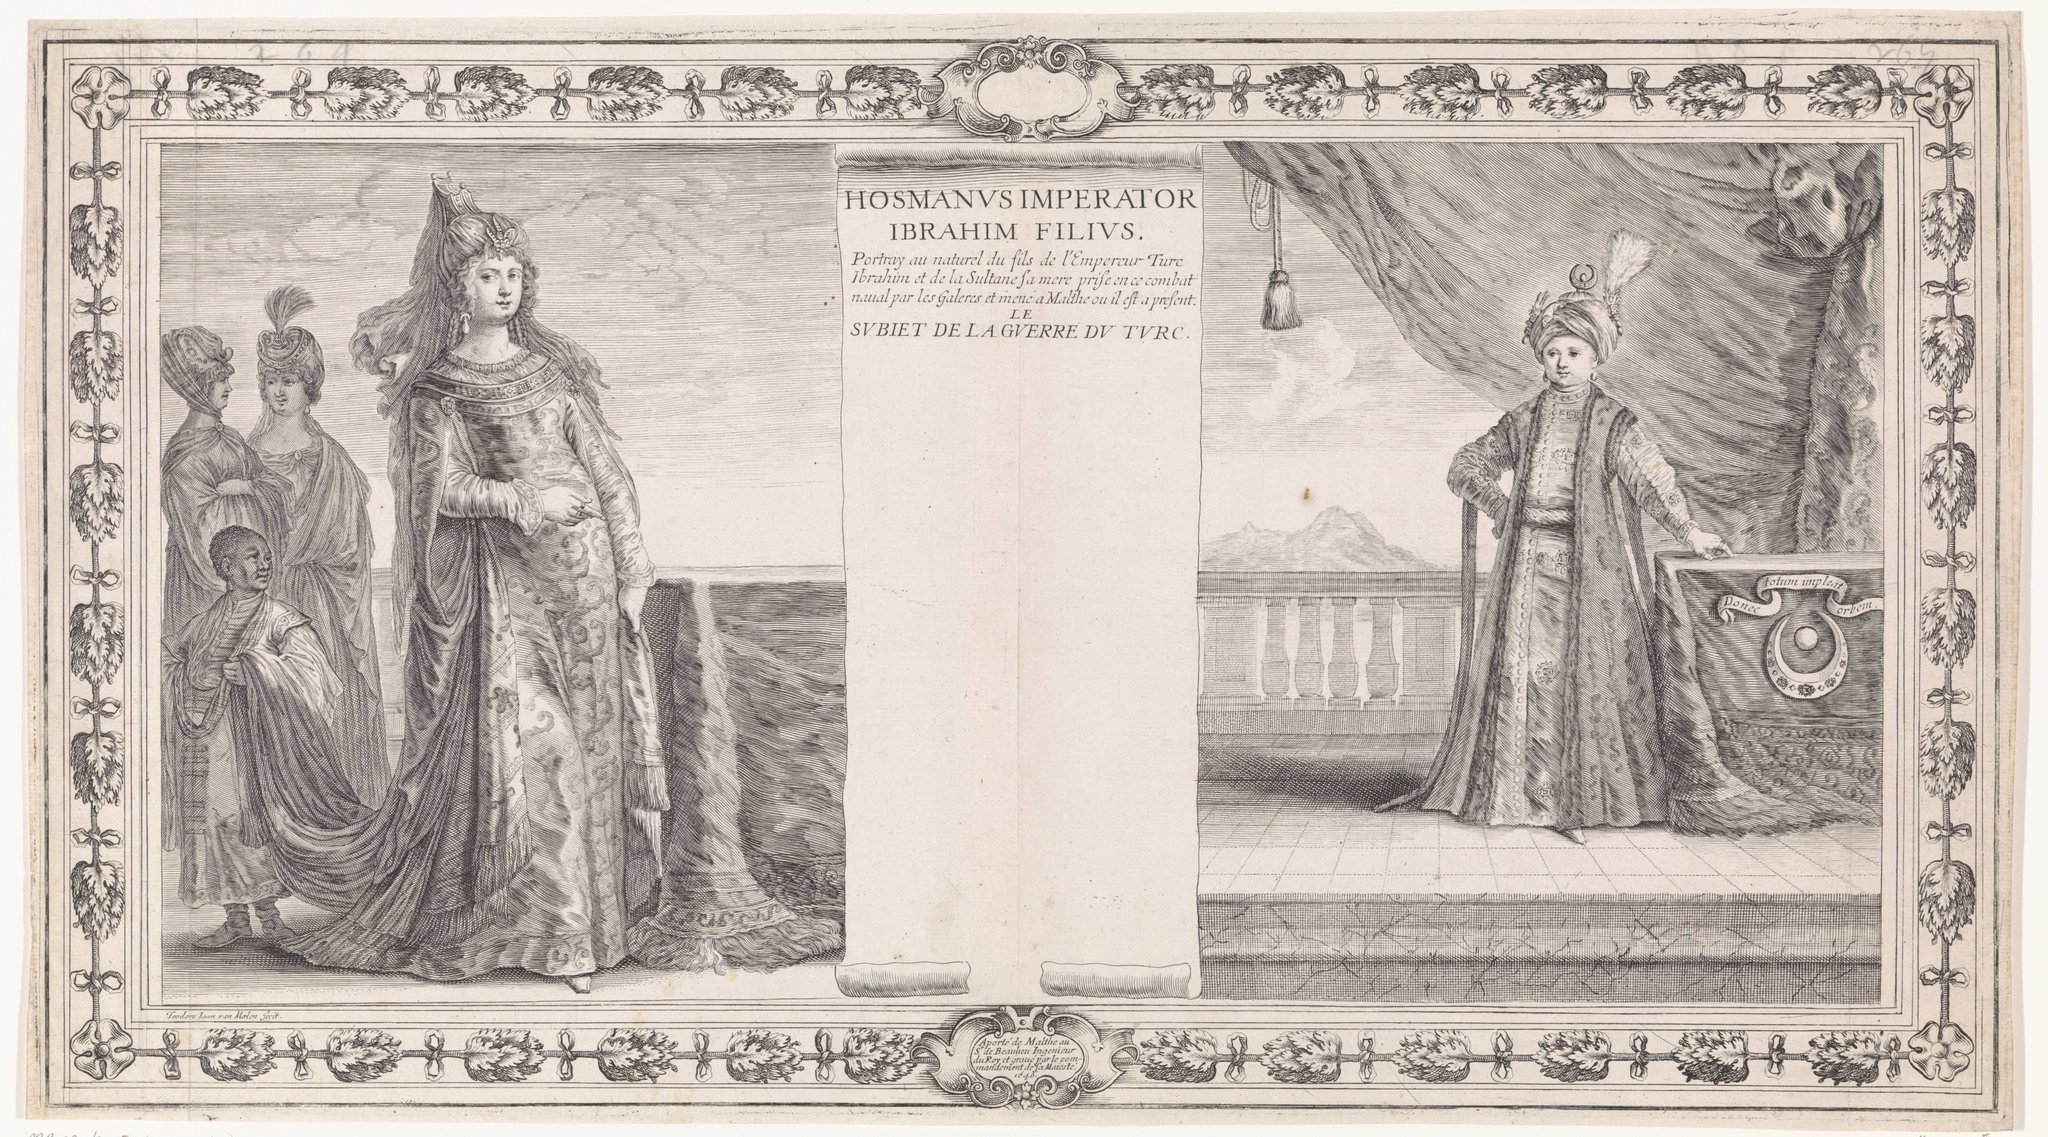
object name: print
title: Portret van Mehmet IV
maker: theodor van merlen (ii)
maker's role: print maker, publisher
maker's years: 1609-1672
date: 1646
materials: paper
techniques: engraving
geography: antwerp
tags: head-gear: turban, ruler, sovereign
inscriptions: collector's mark: Lugt 240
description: Portret van Mehmet IV, zoon van sultan Ibrahim I van het Ottomaanse Rijk, op jonge leeftijd. Links zijn moeder. Een knecht houdt haar sleep vast. Achter hem staan twee vrouwen. De voorstelling is gevat in een ornamentele lijst.